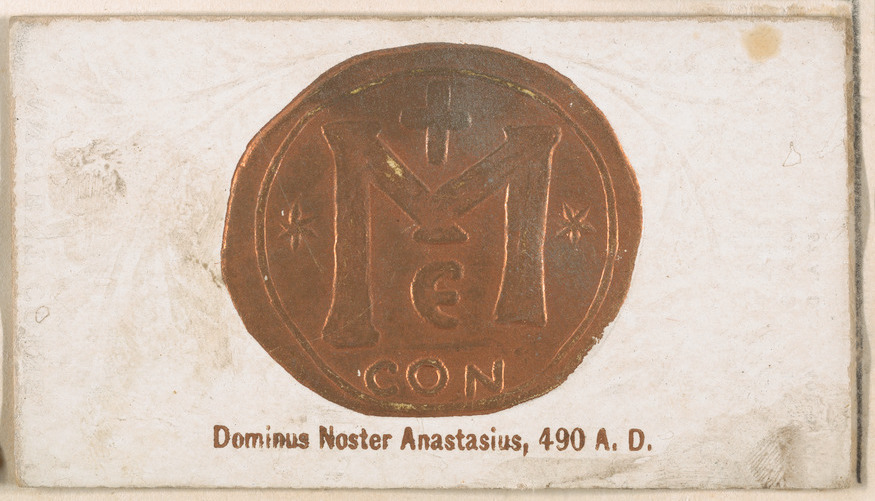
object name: print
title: Dominus Noster Anastasius, 490 A.D., from the Ancient Coins series (N180) issued by Wm. S. Kimball & Co.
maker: william s. kimball & company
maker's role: publisher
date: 1888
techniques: color lithograph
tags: coins